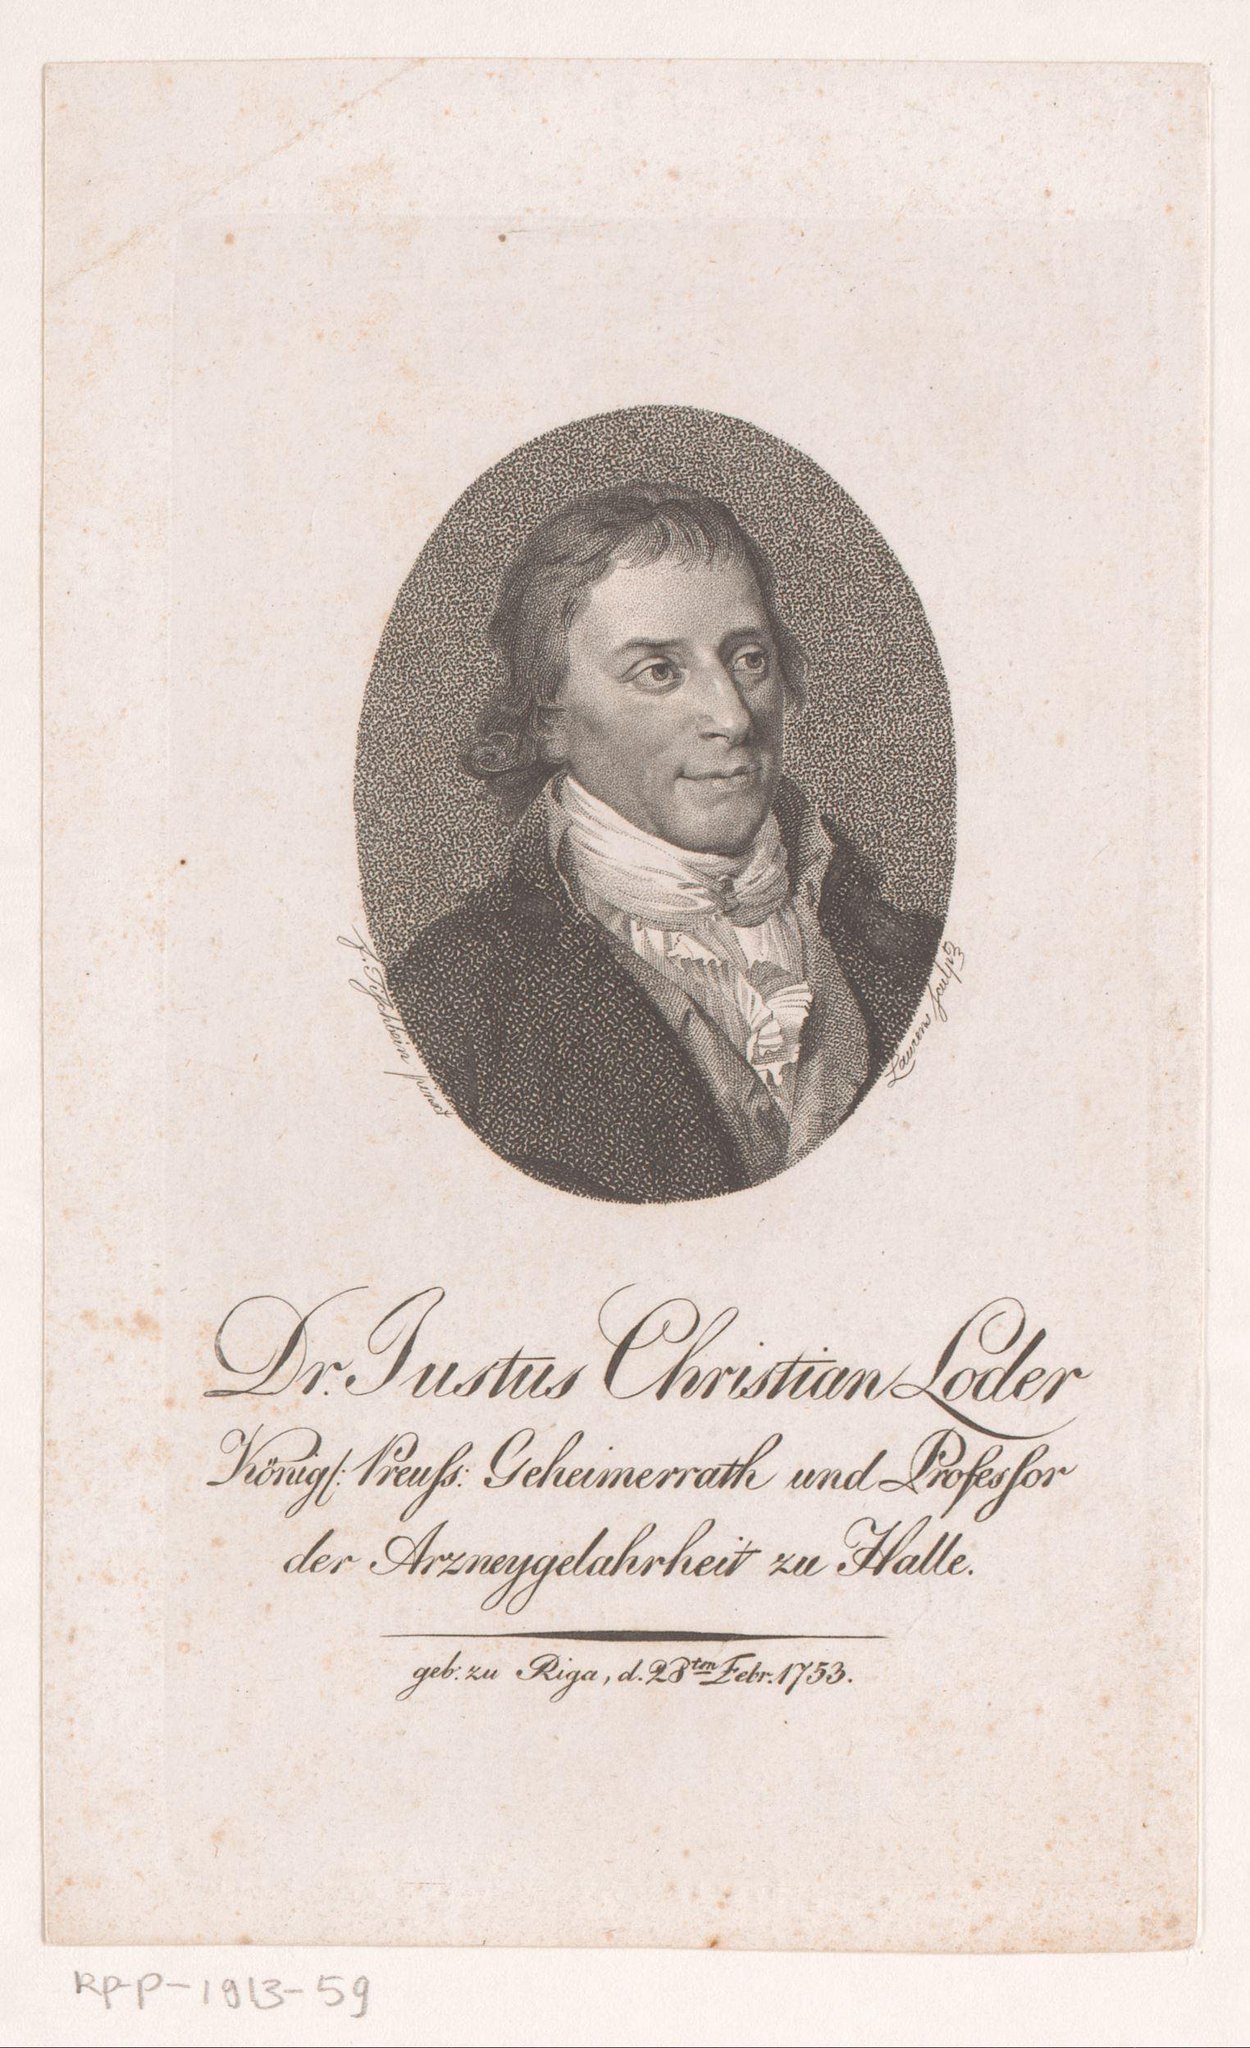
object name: print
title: Portret van Justus Christian von Loder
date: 1780-1832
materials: paper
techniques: stippling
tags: further education (+ portrait of teacher, professor), historical persons, physician, doctor (+ portrait of scholar, scientist)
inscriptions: collector's mark: Lugt 2228